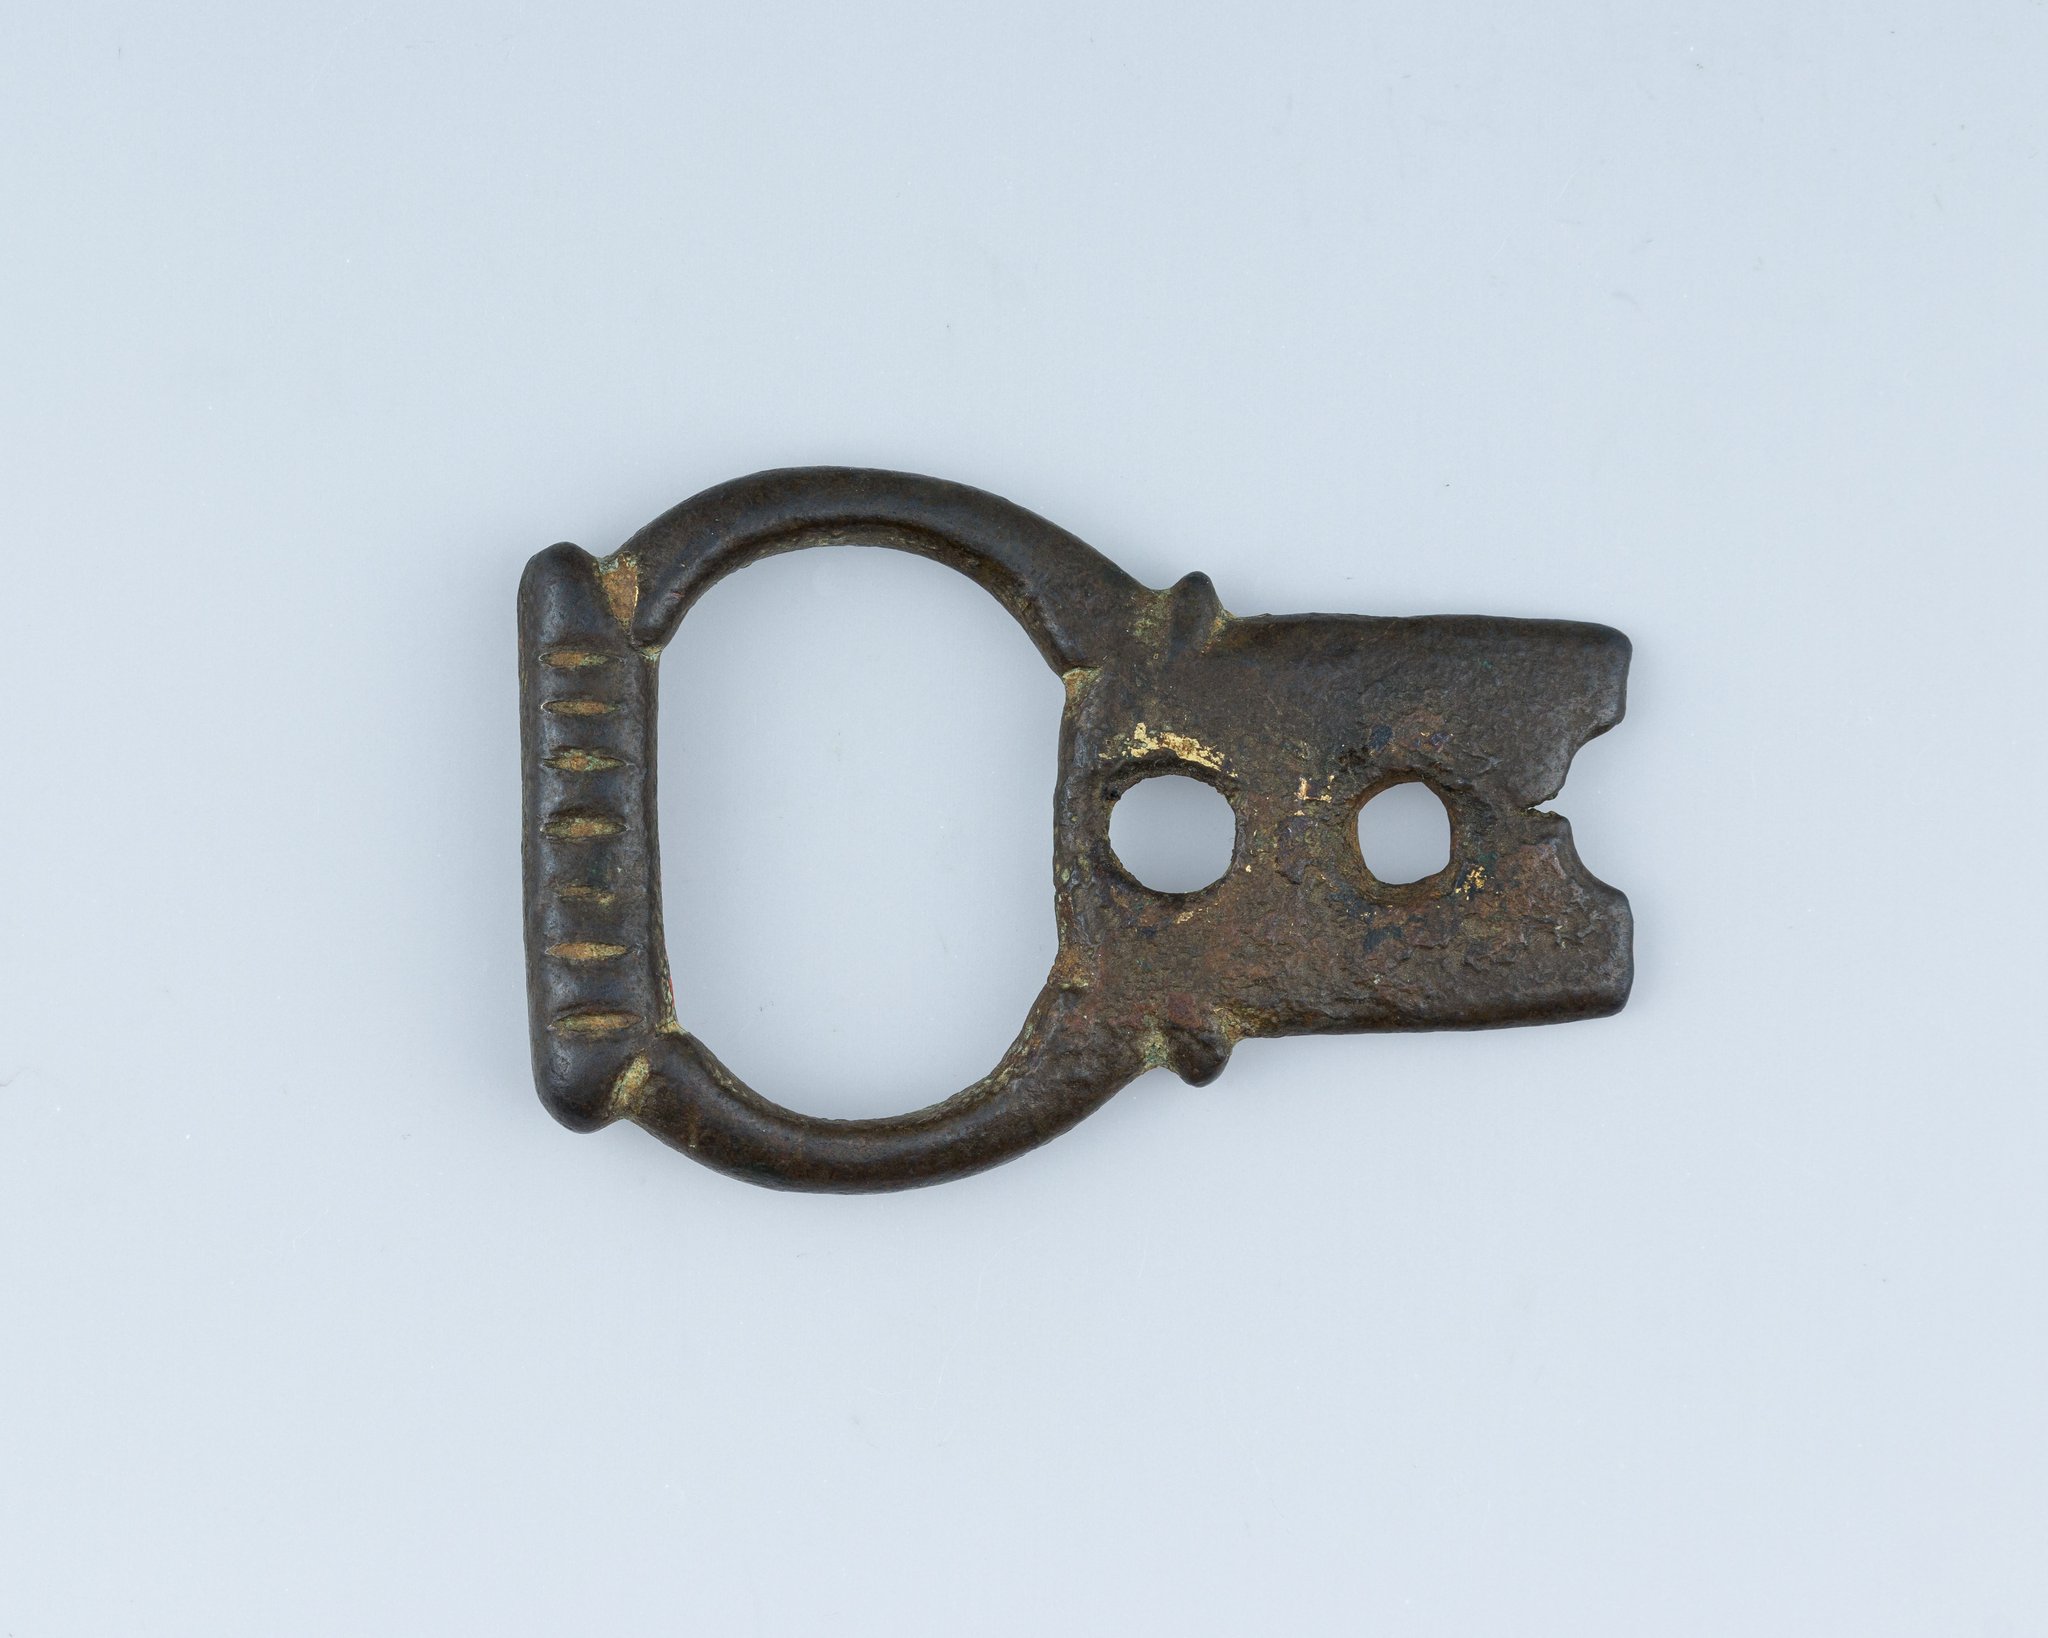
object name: buckle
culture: french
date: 1301-1400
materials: bronze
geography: france